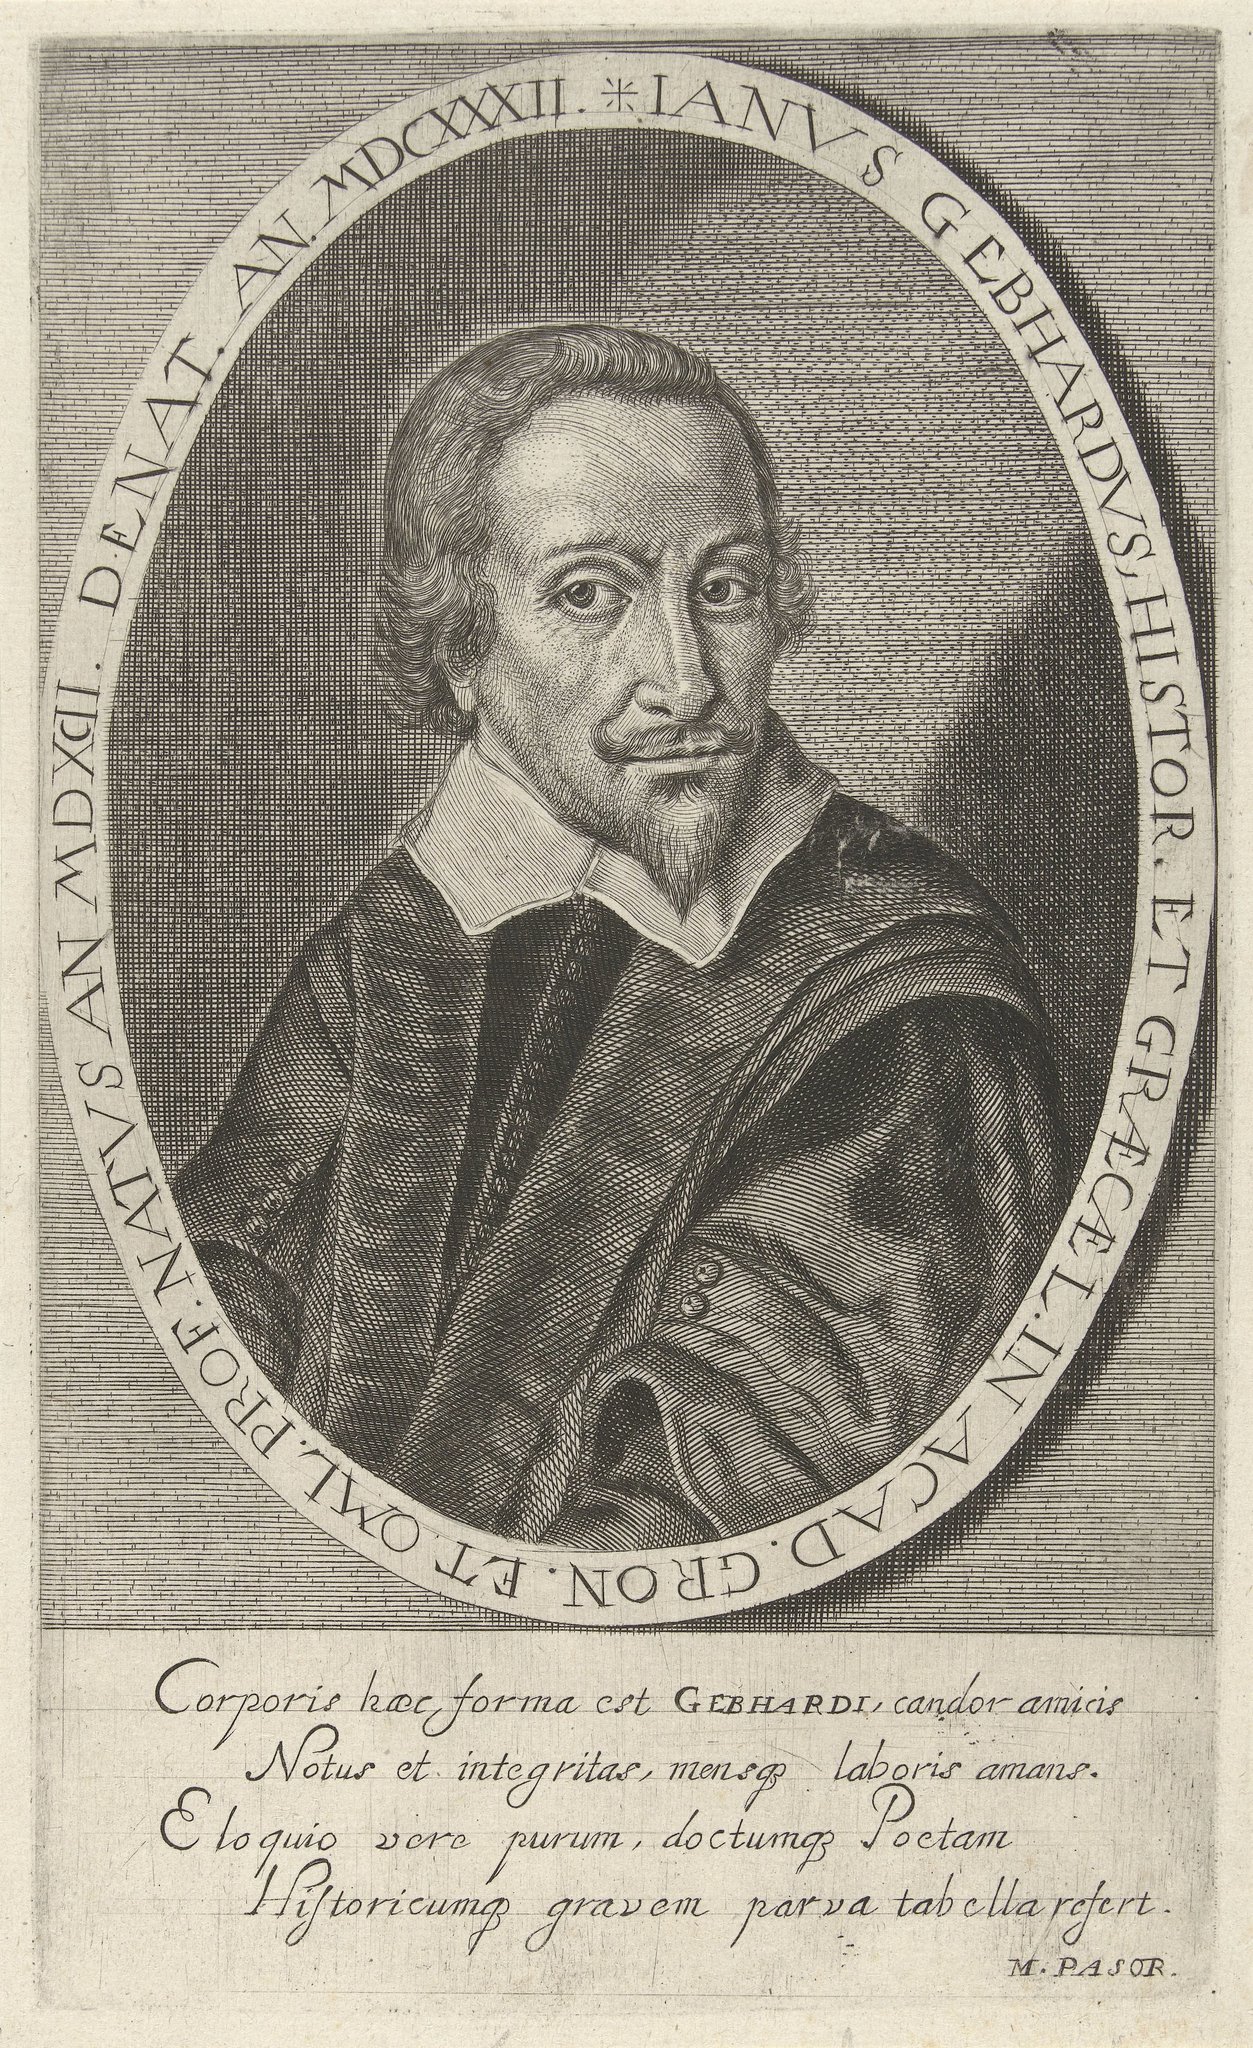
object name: print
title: Portret van Jan Gebhard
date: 1654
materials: paper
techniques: engraving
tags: historicus, professor, jan gebhard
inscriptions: collector's mark: Lugt 2228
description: Portretbuste in ovaal naar links van Jan Gebhard, hoogleraar in de geschiedenis te Groningen. Het hoofd is onbedekt en naar rechts gedraaid. Op de ovale omlijsting staat een randschrift in Latijn, in de marge een vierregelig Latijns vers.